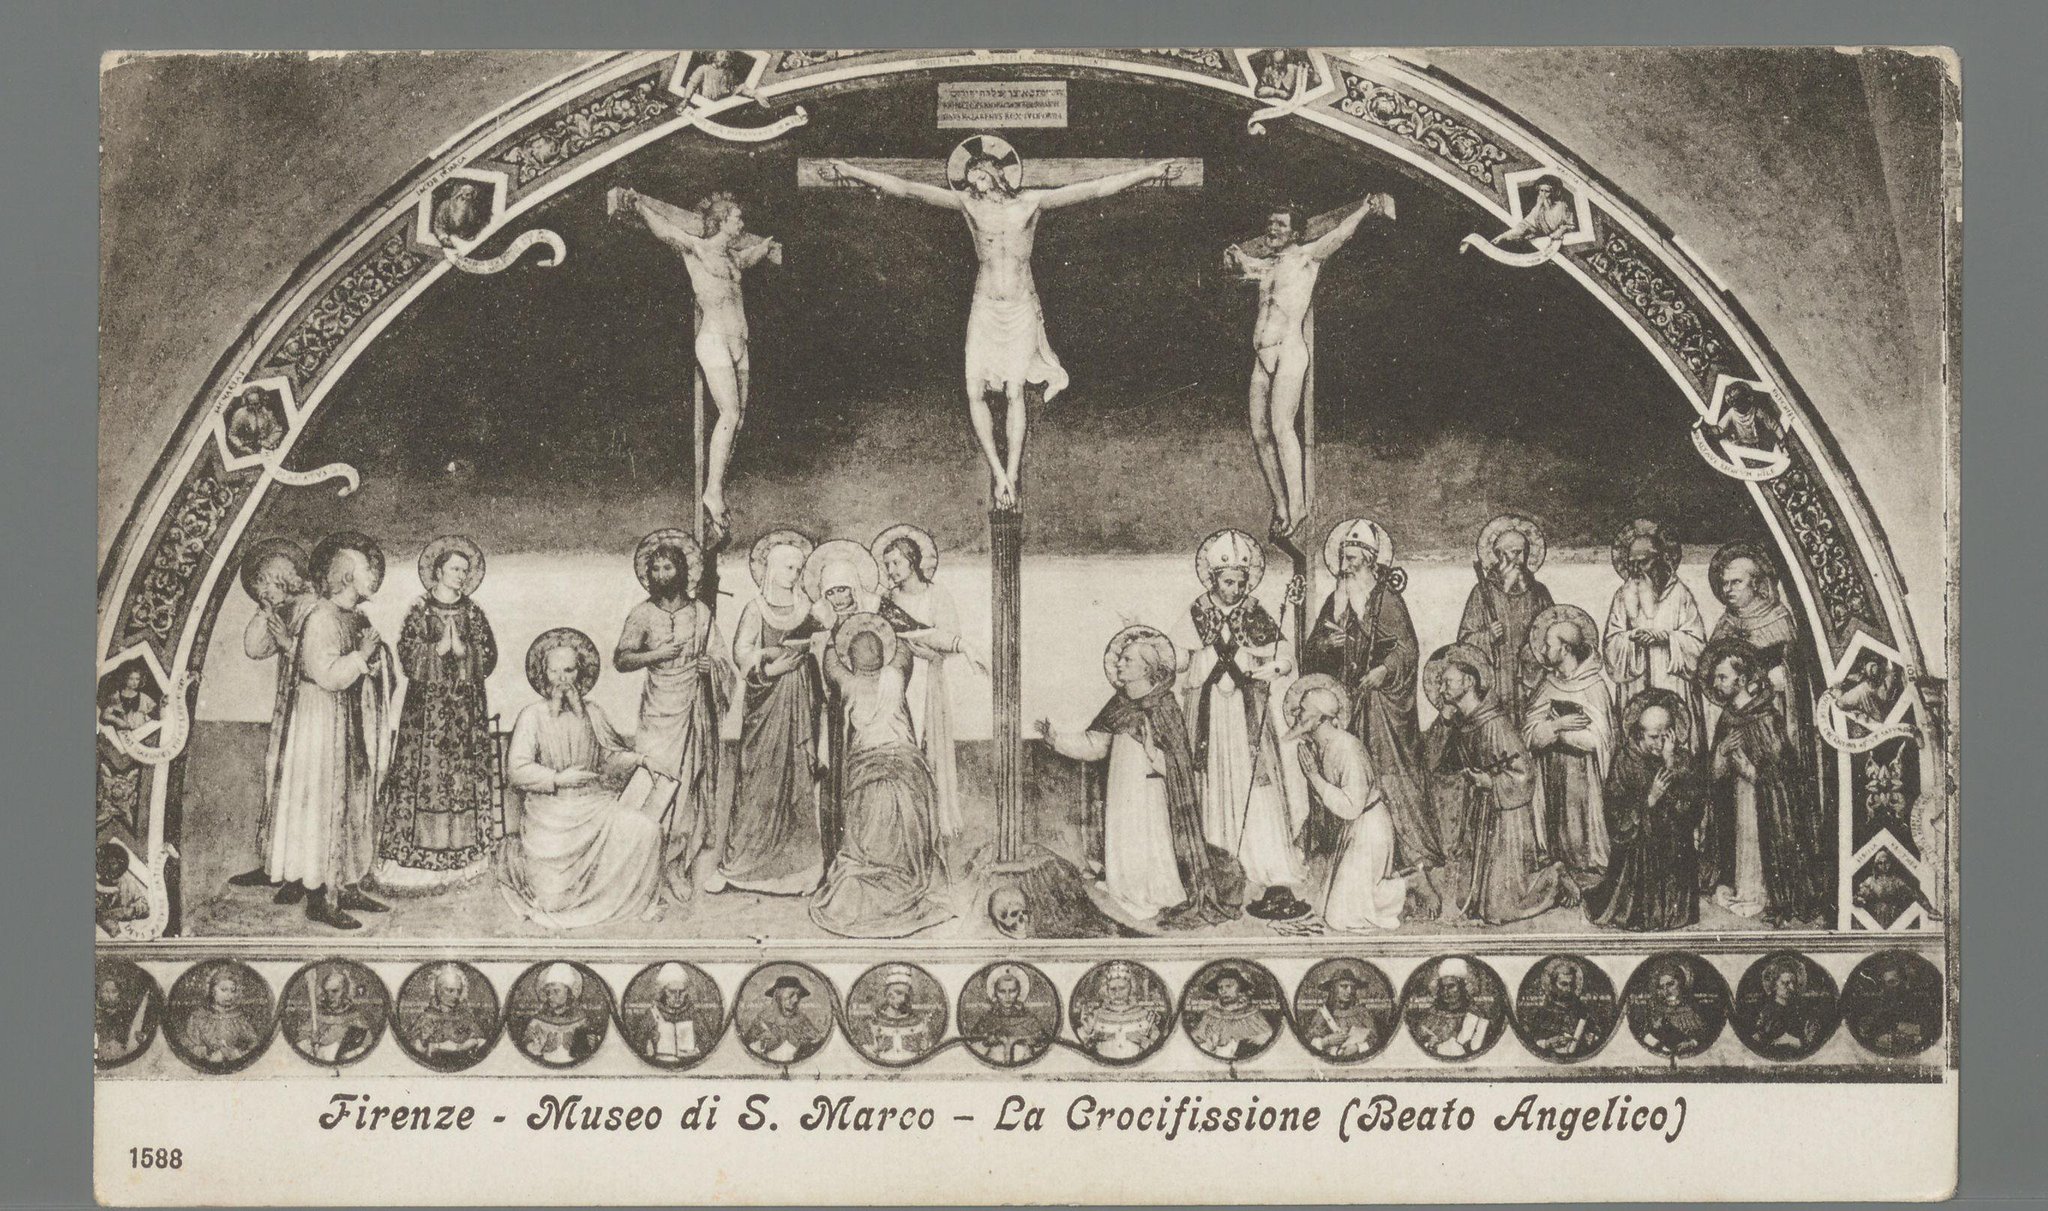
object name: reproduction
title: Firenze - Museo di S. Marco - La Crocifissione (Beato Angelico)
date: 1906-1930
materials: cardboard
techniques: photograph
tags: permanent exhibition, museum, picture, painting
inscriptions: collector's mark: ‘AFE v S’, monogram